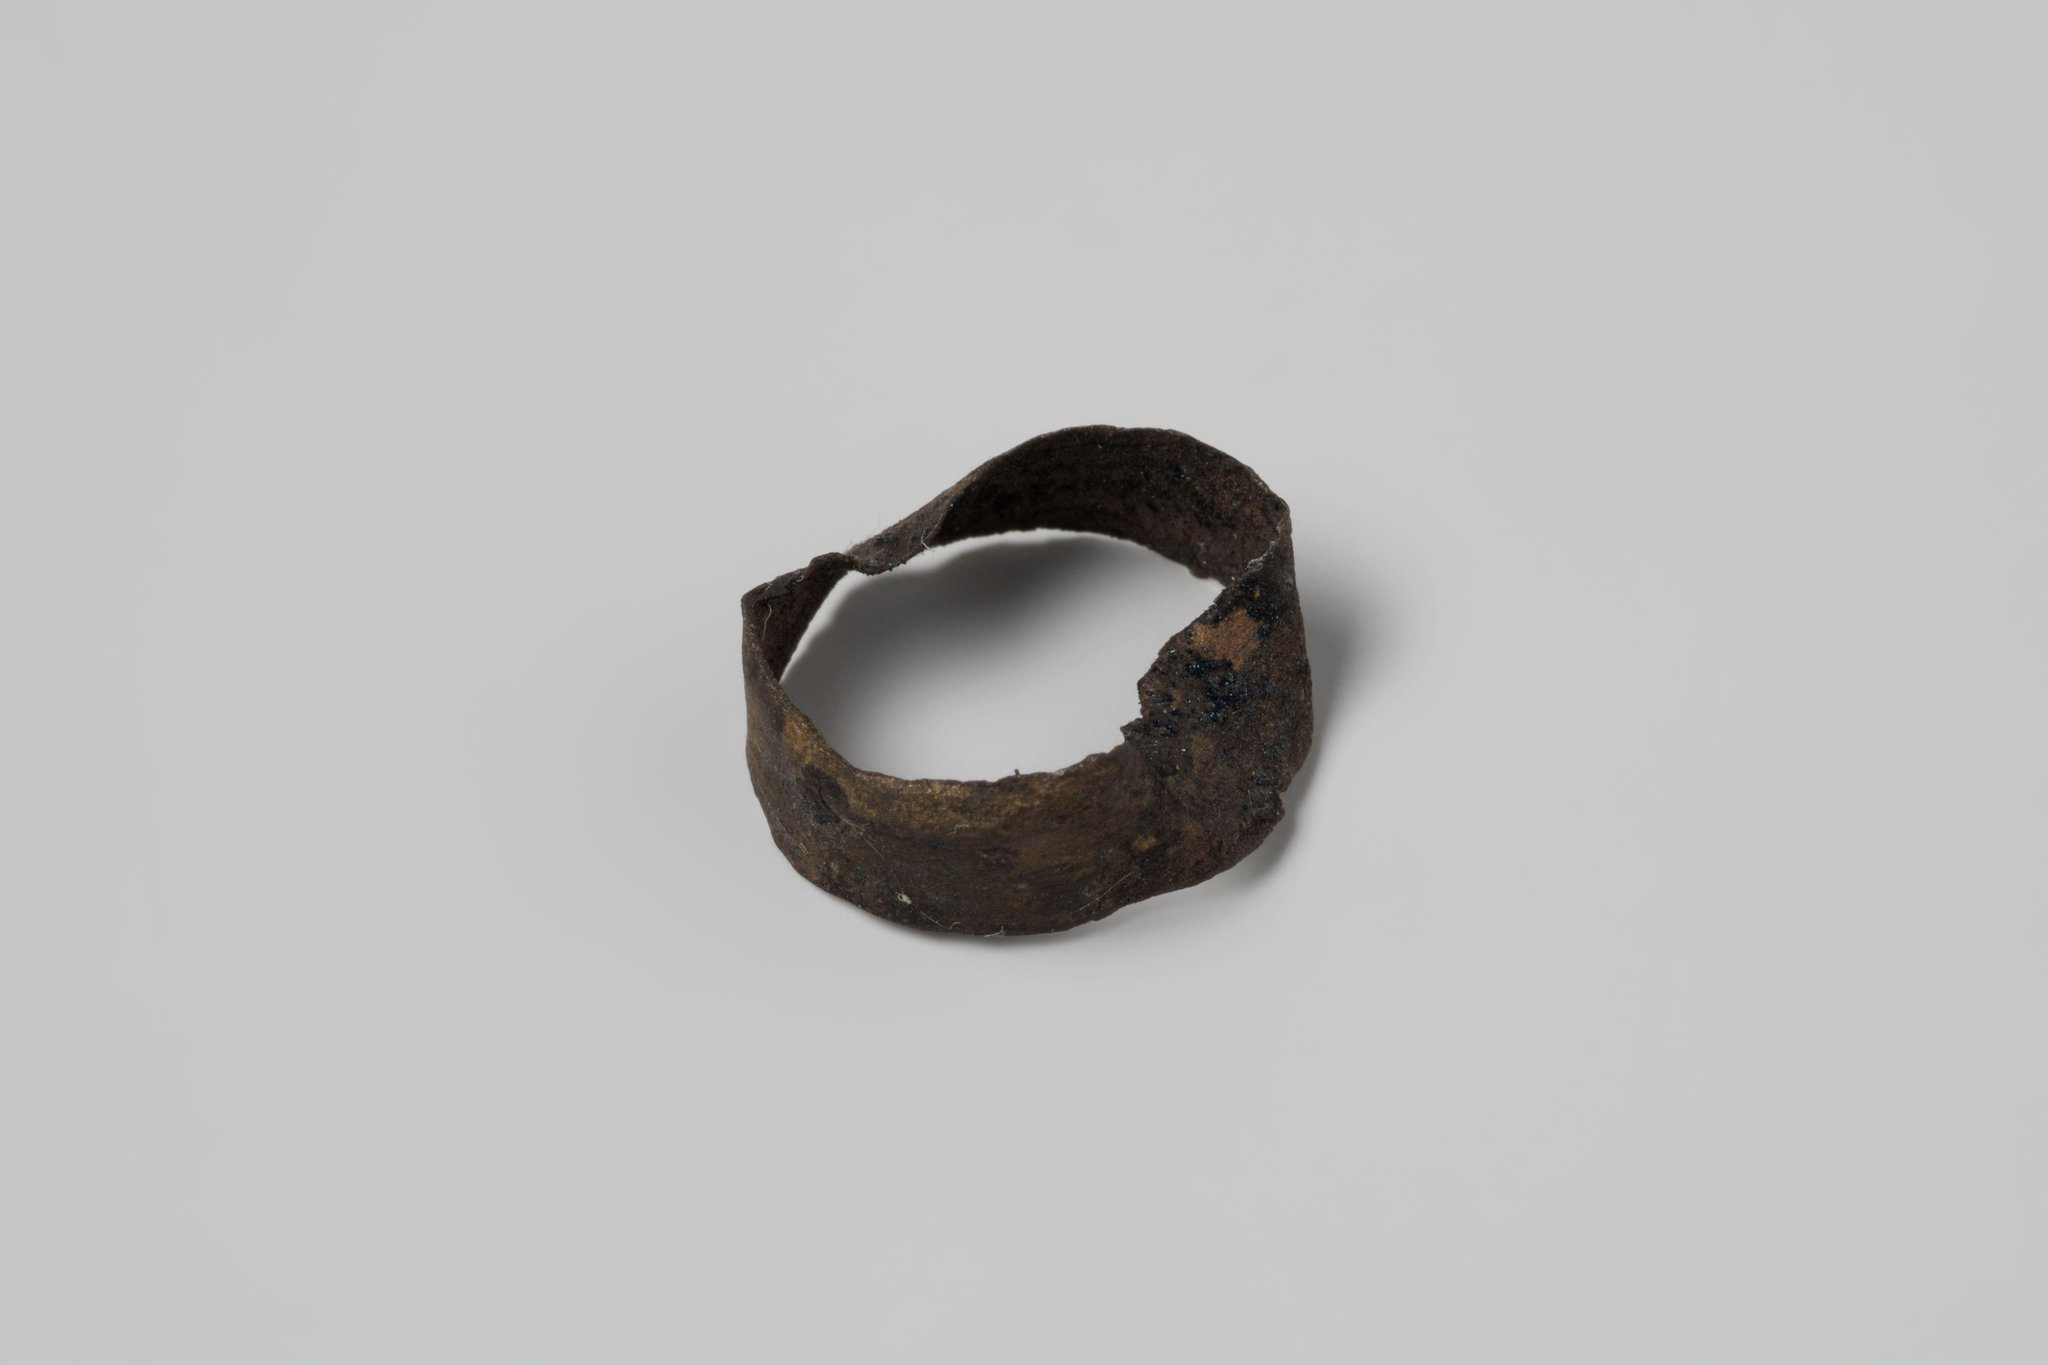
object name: knife handle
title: Messenheftring uit het wrak van de Oost-Indiëvaarder Hollandia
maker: Anonymous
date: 1700-1743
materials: copper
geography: netherlands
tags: verenigde oostindische compagnie, hollandia (schip), annet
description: Knife-handle, ferrule; id. NG 1980-27H426.